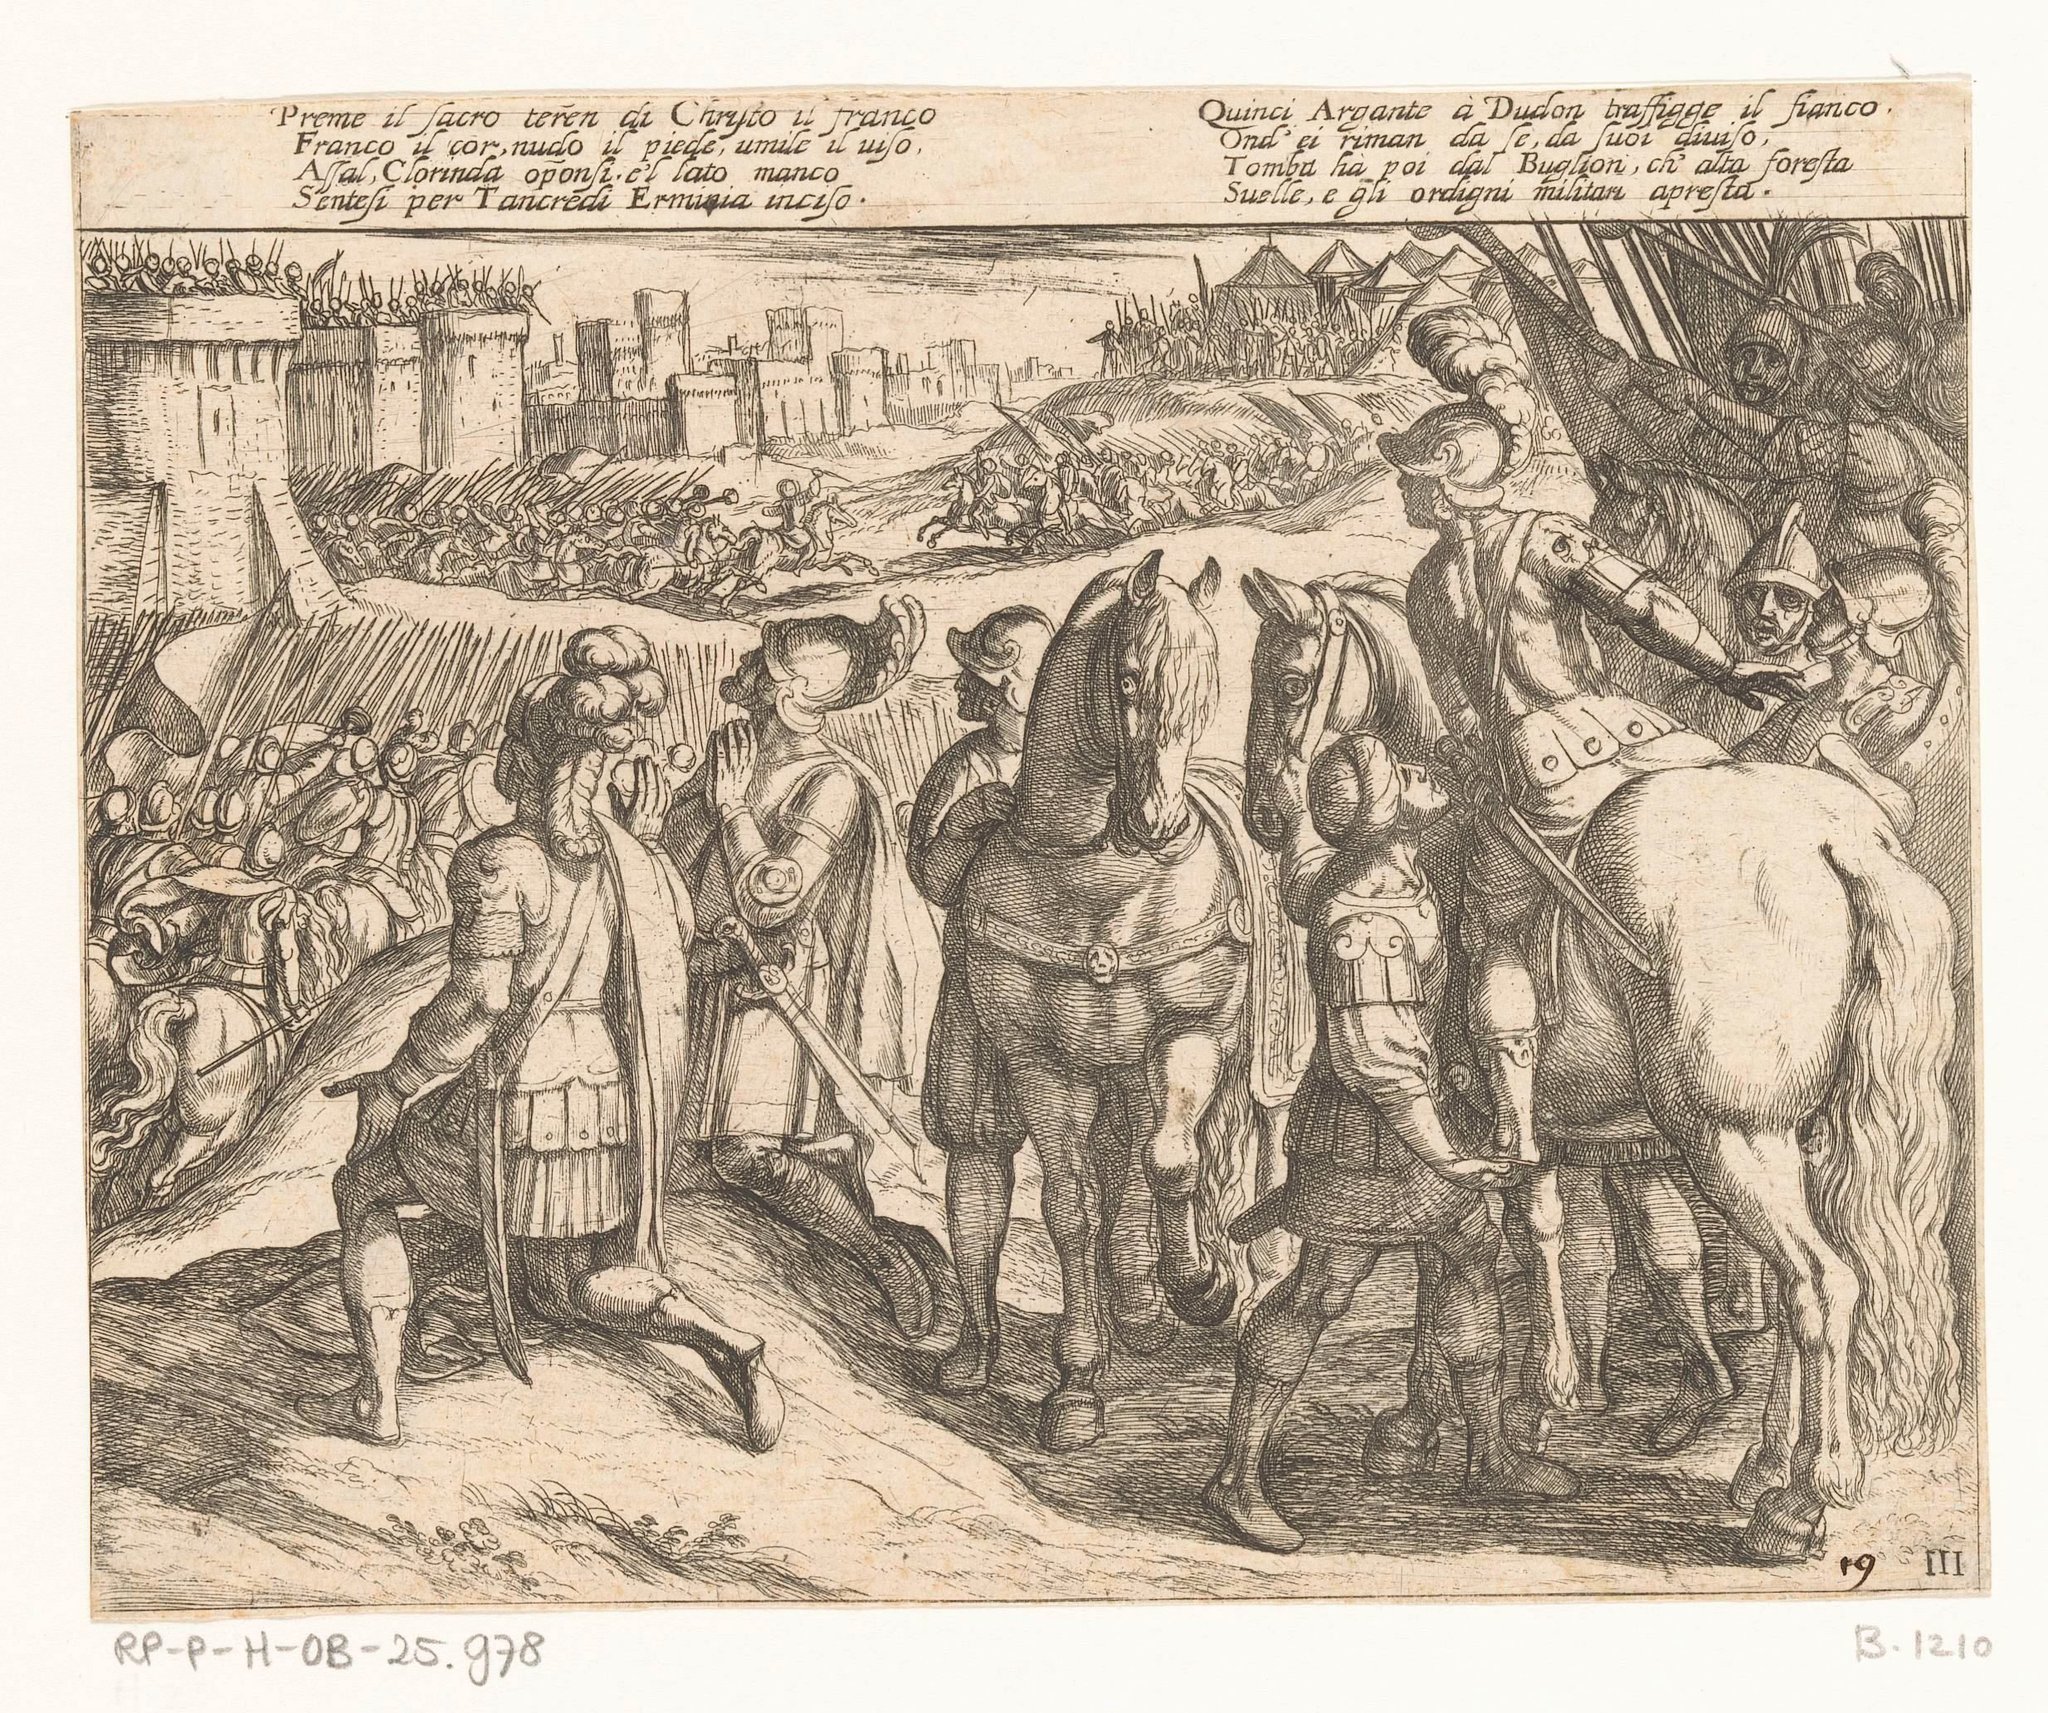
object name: print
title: Gerusalemme Liberata (deel 2)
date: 1565-1630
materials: paper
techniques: etching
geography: italy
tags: battle, militant proselytizing: religious war, crusade, etc., (scenes from) specific works of literature: tasso, gerusalemme liberata, knight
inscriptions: collector's mark: Lugt 11, collector's mark: ‘Hinloopen’, number: ‘19’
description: Deze prent maakt deel uit van een reeks van twintig prenten (+ opdracht) met voorstellingen van scènes uit Tasso's 'Jeruzalem verlost', een episch gedicht geschreven door de Italiaanse dichter Torquato Tasso en voor het eerst gepubliceerd in 1581. Het verhaal vertelt grotendeels in fictie over de Eerste Kruistocht waarin de christenen, geleid door Godfried van Bouillon, de strijd aangaan met de moslims om het Beleg van Jeruzalem.